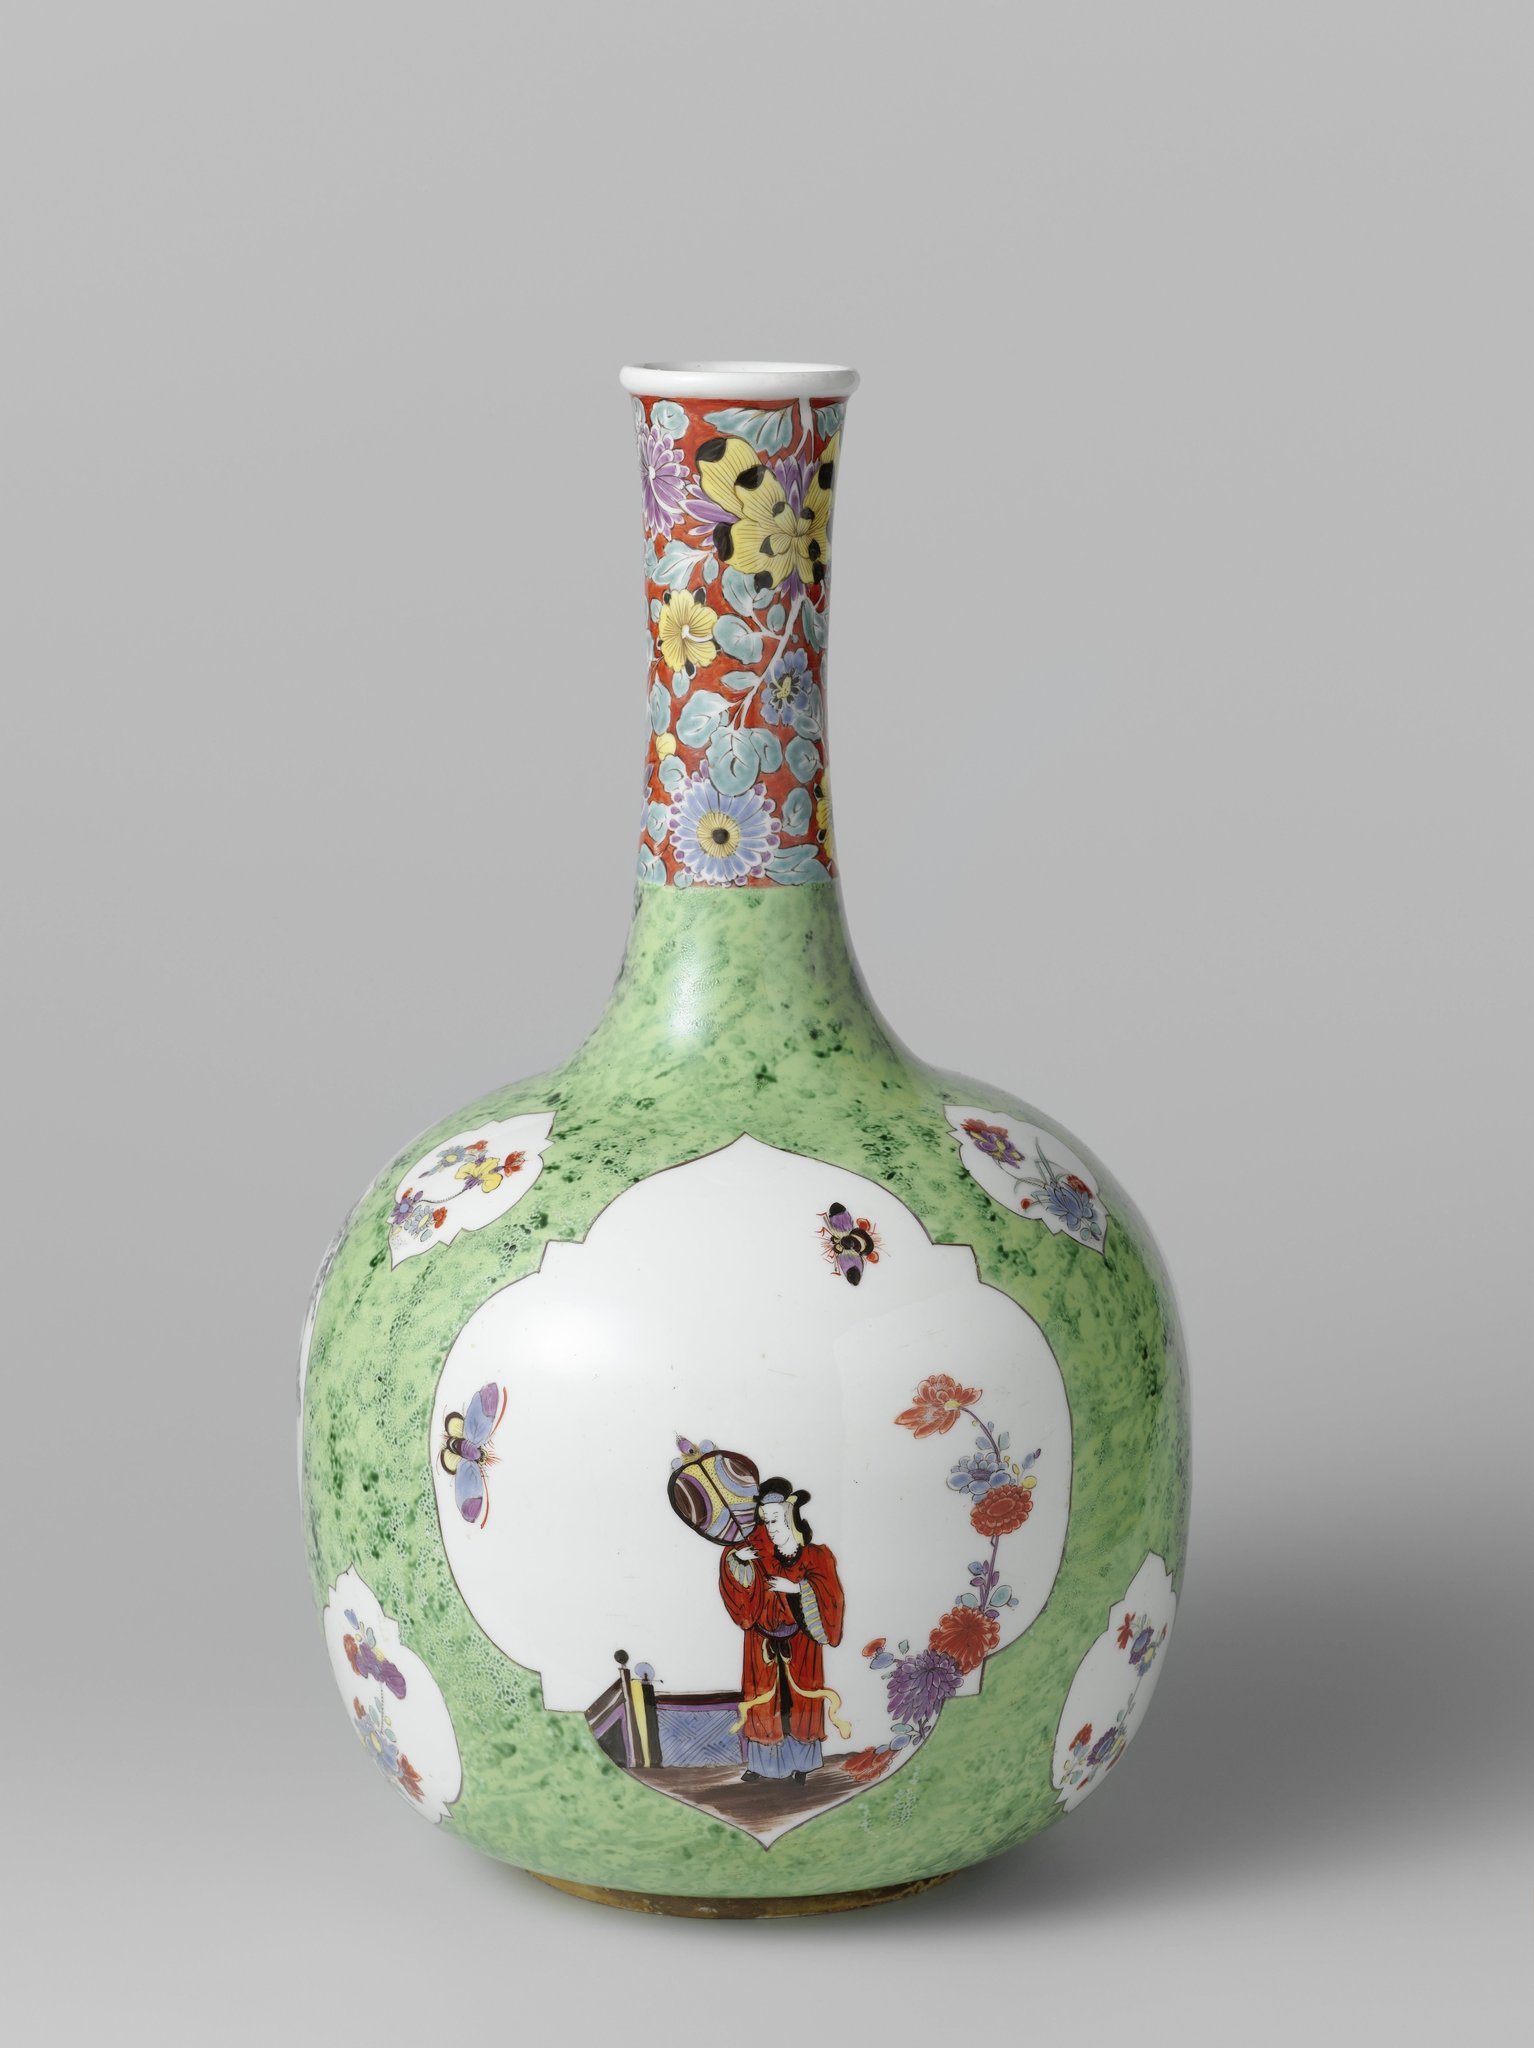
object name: vase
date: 1730-1735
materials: porcelain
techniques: painted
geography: meissen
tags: chinese (+ costume)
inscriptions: factory mark: ‘AR’, mold mark: ‘X (Rückert 1996, afb. 6, nr. 33)’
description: Vaas van beschilderd porselein. De vaas heeft een afgeplat bolvormig lichaam en een lange slanke hals. Het lichaam is bedekt met een lichtgroene gemarmerde fond, de hals met bloemen op een rode fond. In de groene fond zijn drie grote en zes kleine vierpassen uitgespaard. In de grote is steeds een staande Chinees met een grote waaier bij een hek en bloeiende planten geschilderd, in de kleine bloemtakken. De vaas is gemerkt.